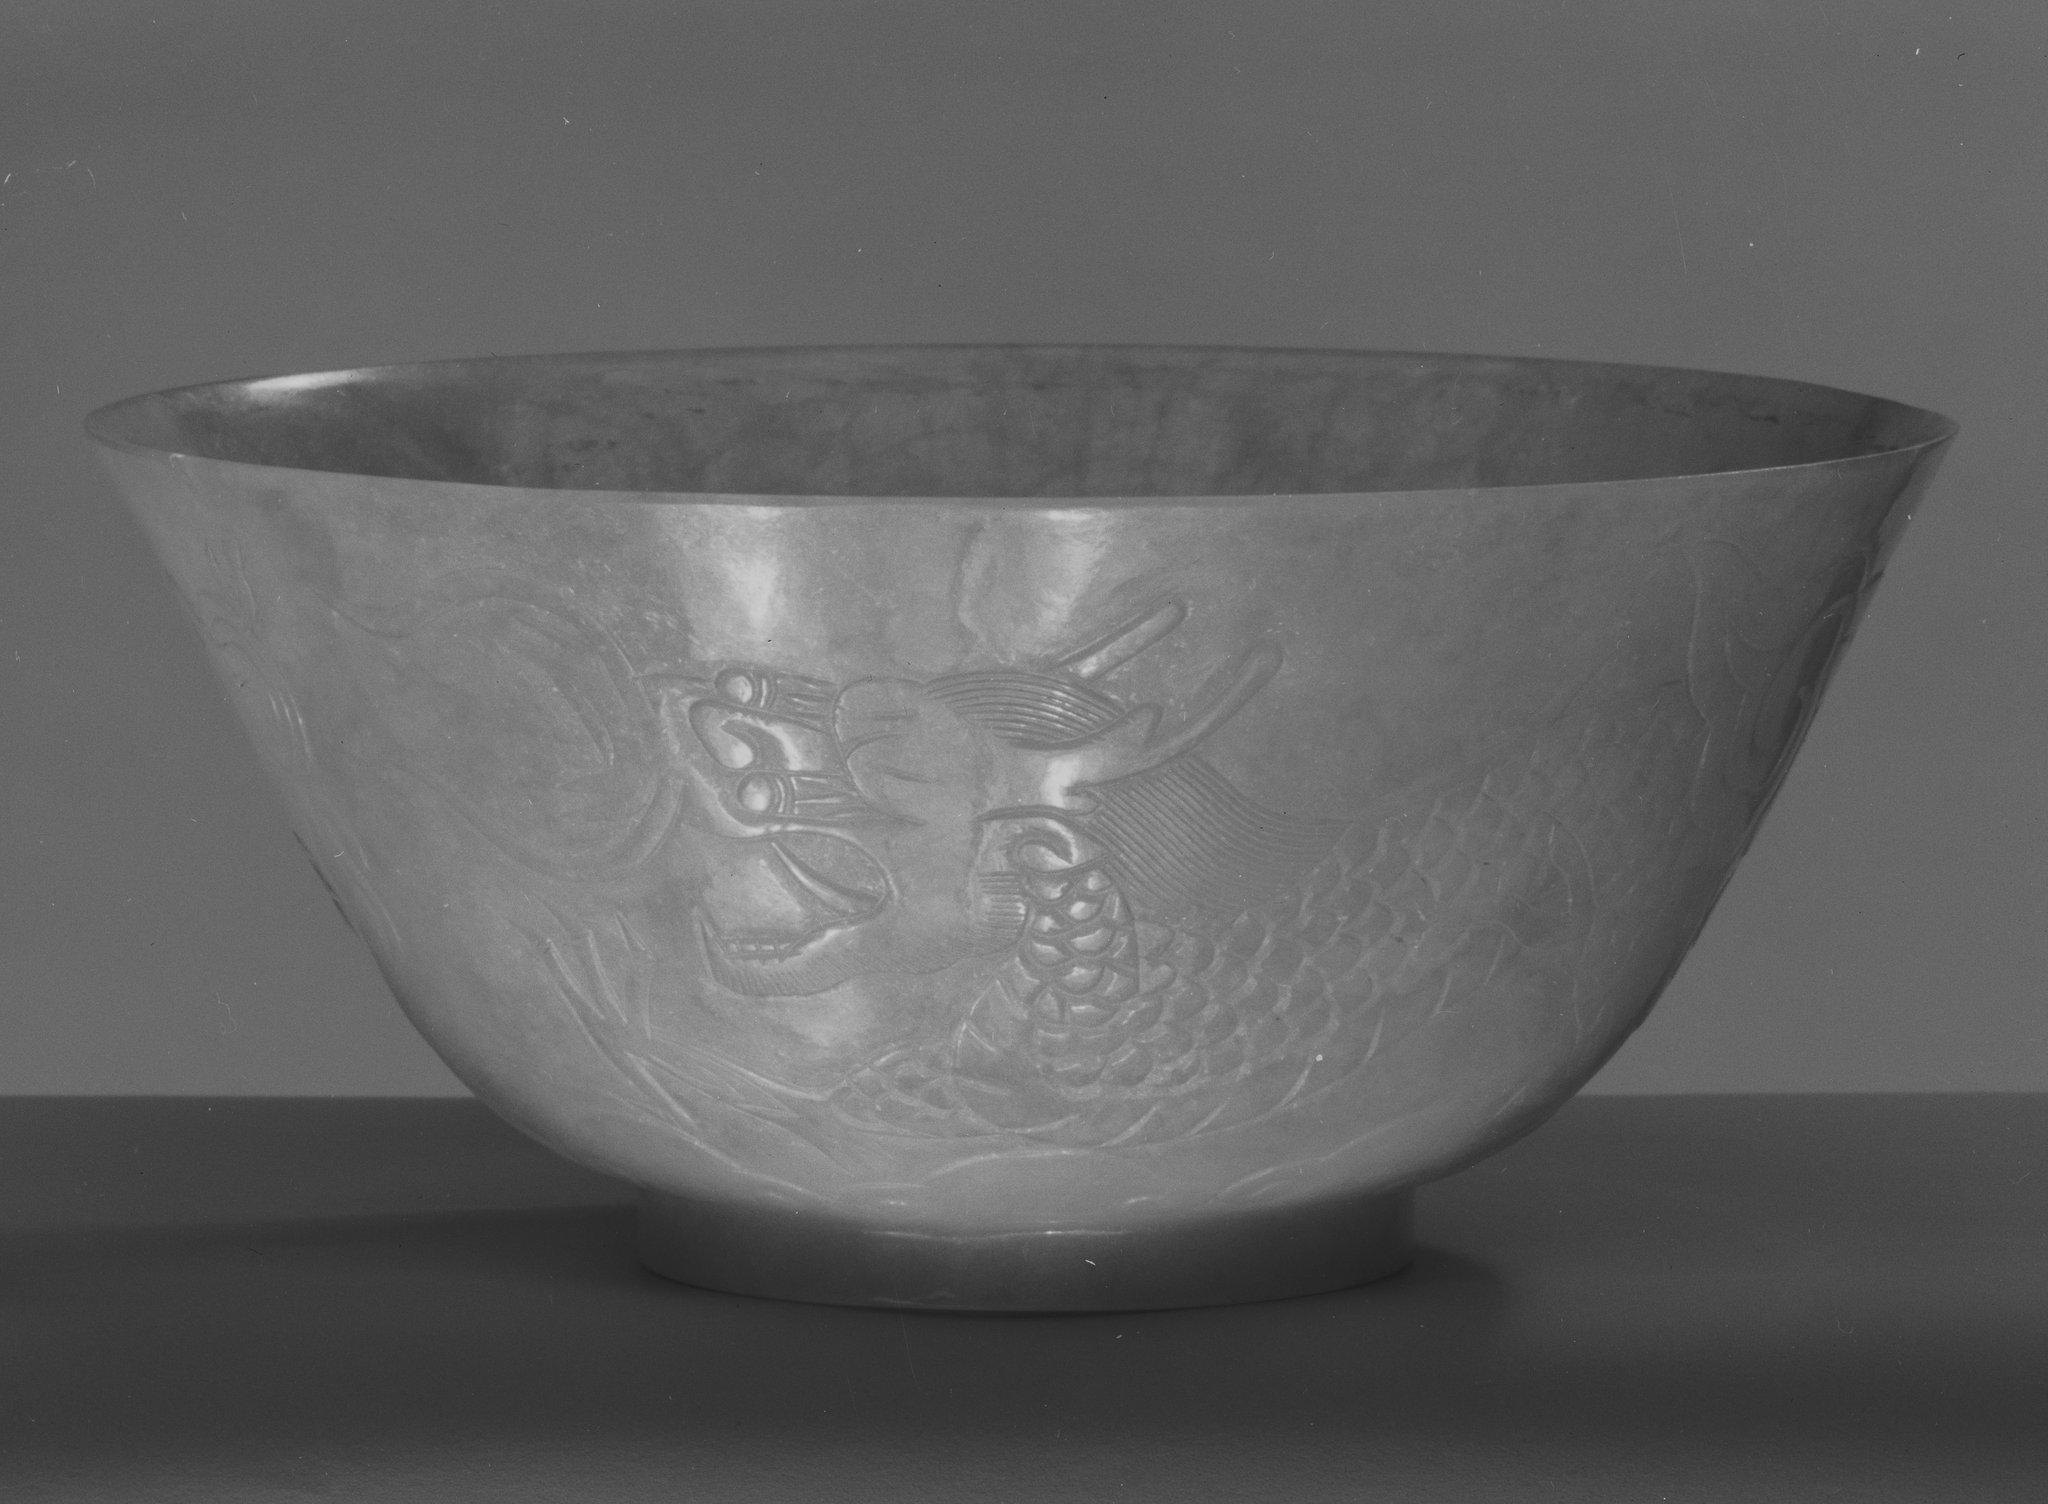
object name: bowl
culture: chinese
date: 1867-1900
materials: jade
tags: mythical creatures